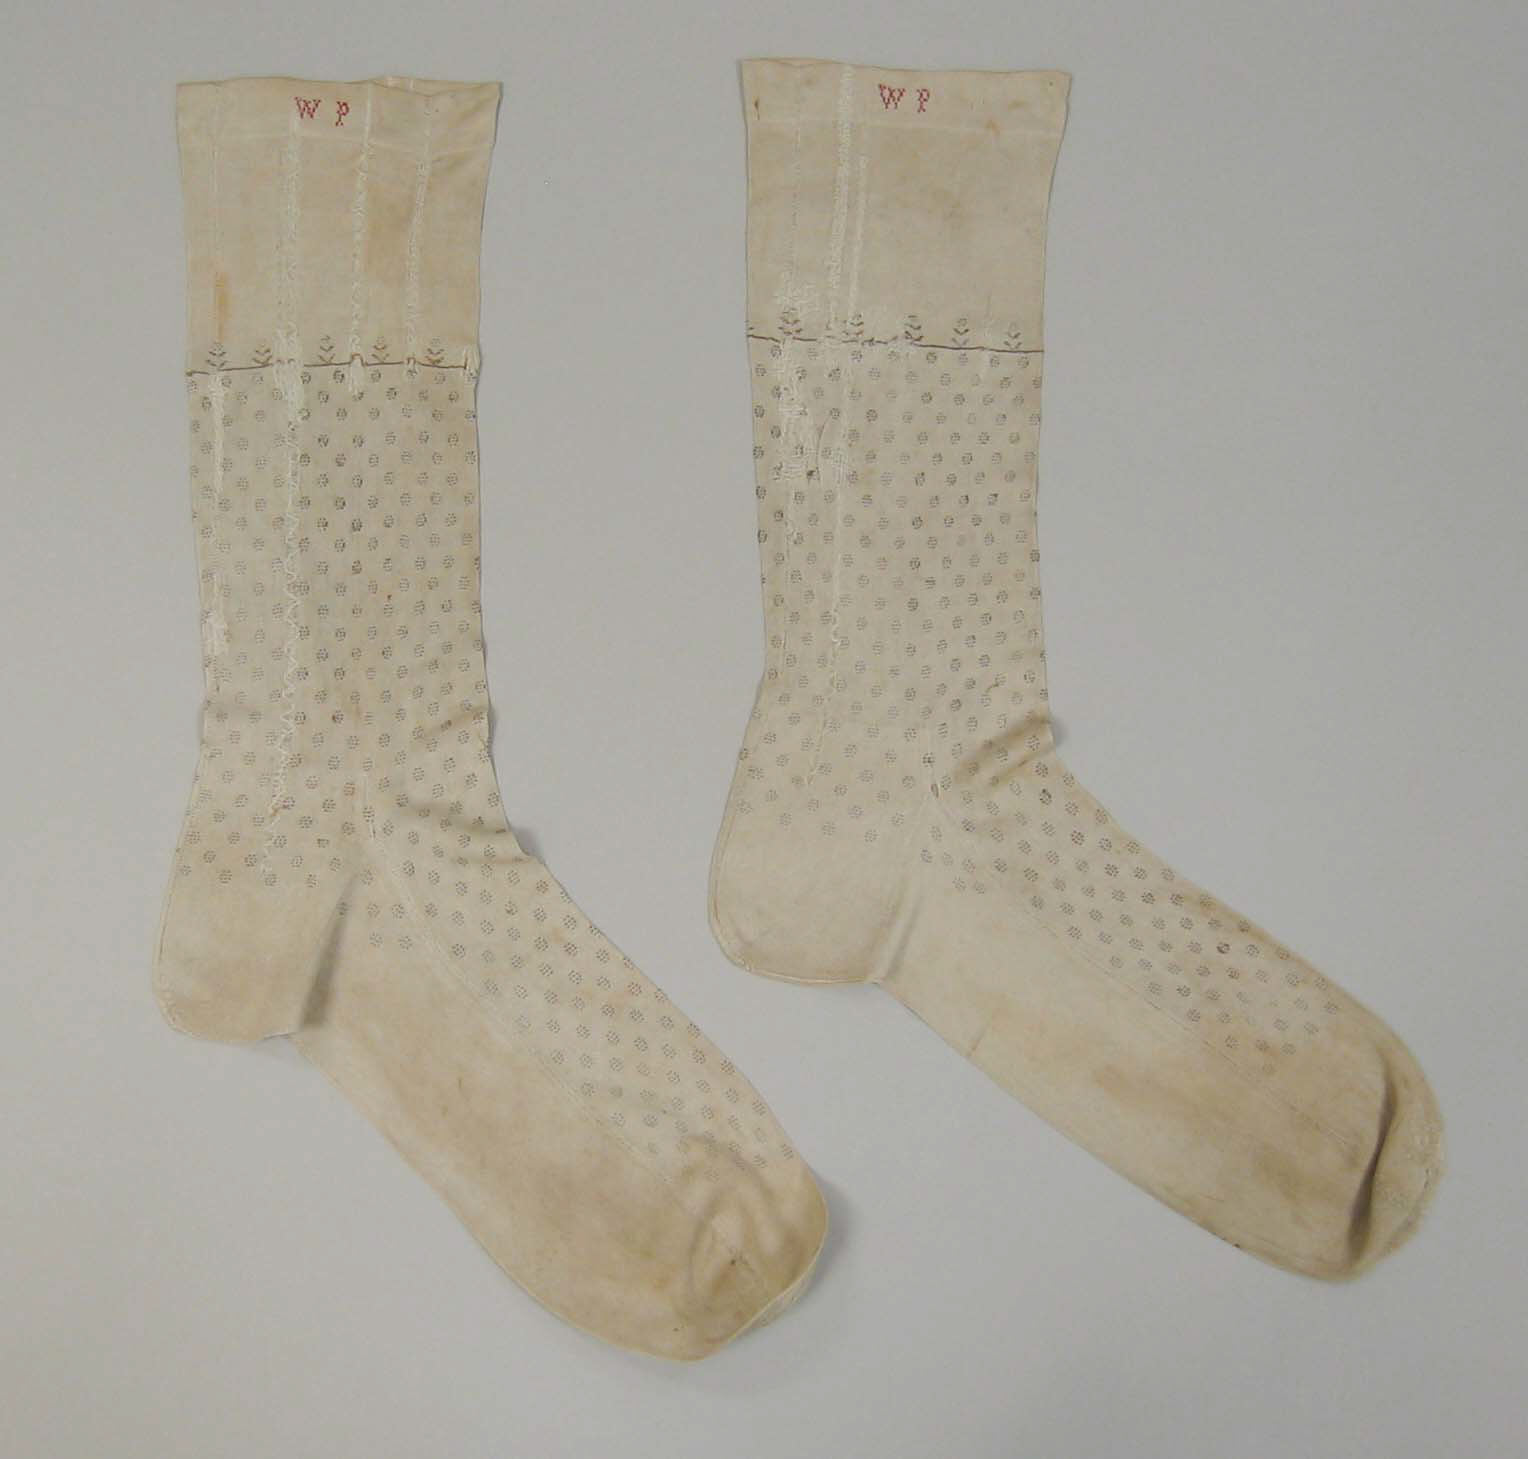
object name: sock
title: Socks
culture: american or european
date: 1820-1829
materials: silk